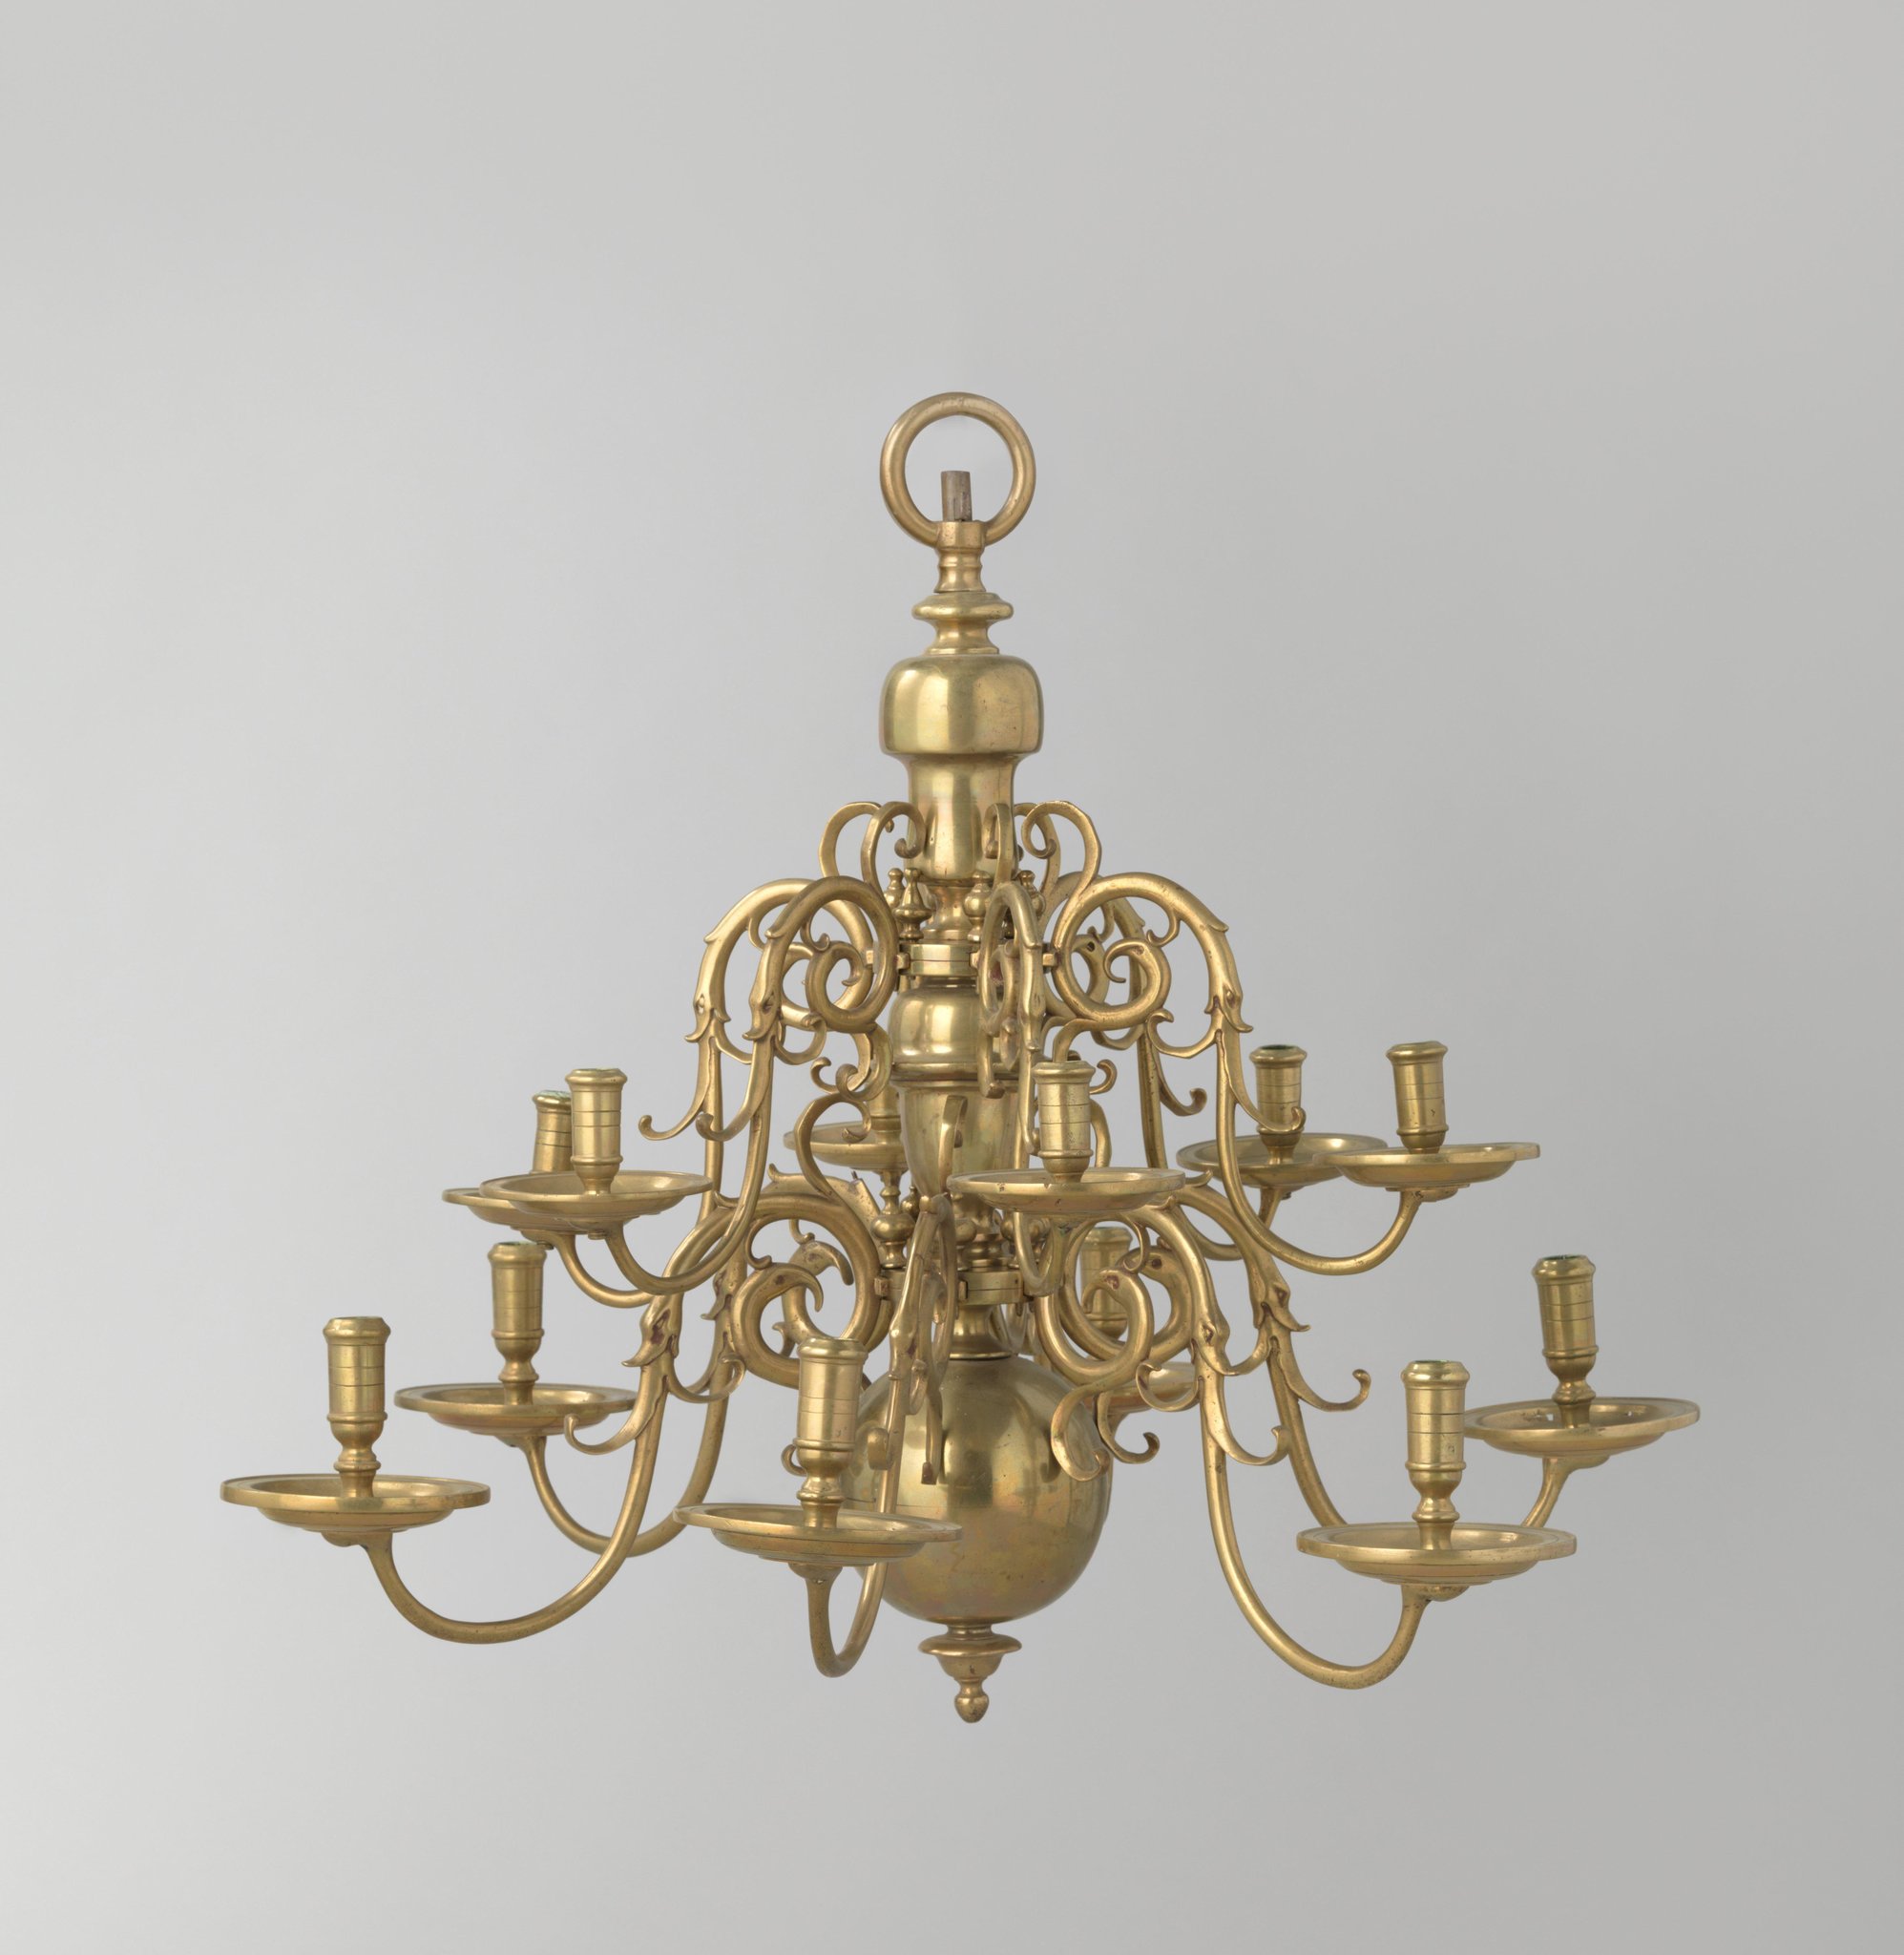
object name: chandelier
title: Arm met kaarsenhouder van kaarsenkroon van twee hoogten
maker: Anonymous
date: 1800-1875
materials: brass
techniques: casting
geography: netherlands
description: Kaarsenarm behorende bij een messing kaarsenkroon van twee hoogten. De S-vormige arm heeft een krul bij de aanzet, halverwege een dolfijnenkop en gaat naar buiten toe over in het platte verdikking met een schroefgat. Daarin is de kaarsenhouder met de vetvanger vastgezet. De vetvanger is aan de onderzijde geribd geprofileerd rond de opening en heeft een naar onder en naar boven toe iets uitstekend randje en is versierd met gegroefde forse ringen. De cylindrische kaarsenhouder heeft een geprofileerde en een weinig uitstekende rand, twee gegroefde ringen, een rib en een geprofileerd holrond onderstuk, dat overgaat in een uitsteeksel met een schroefdraad met een centergat. Dit is de tweede arm van de bovenste standring, genummerd met 2 ronde punten.